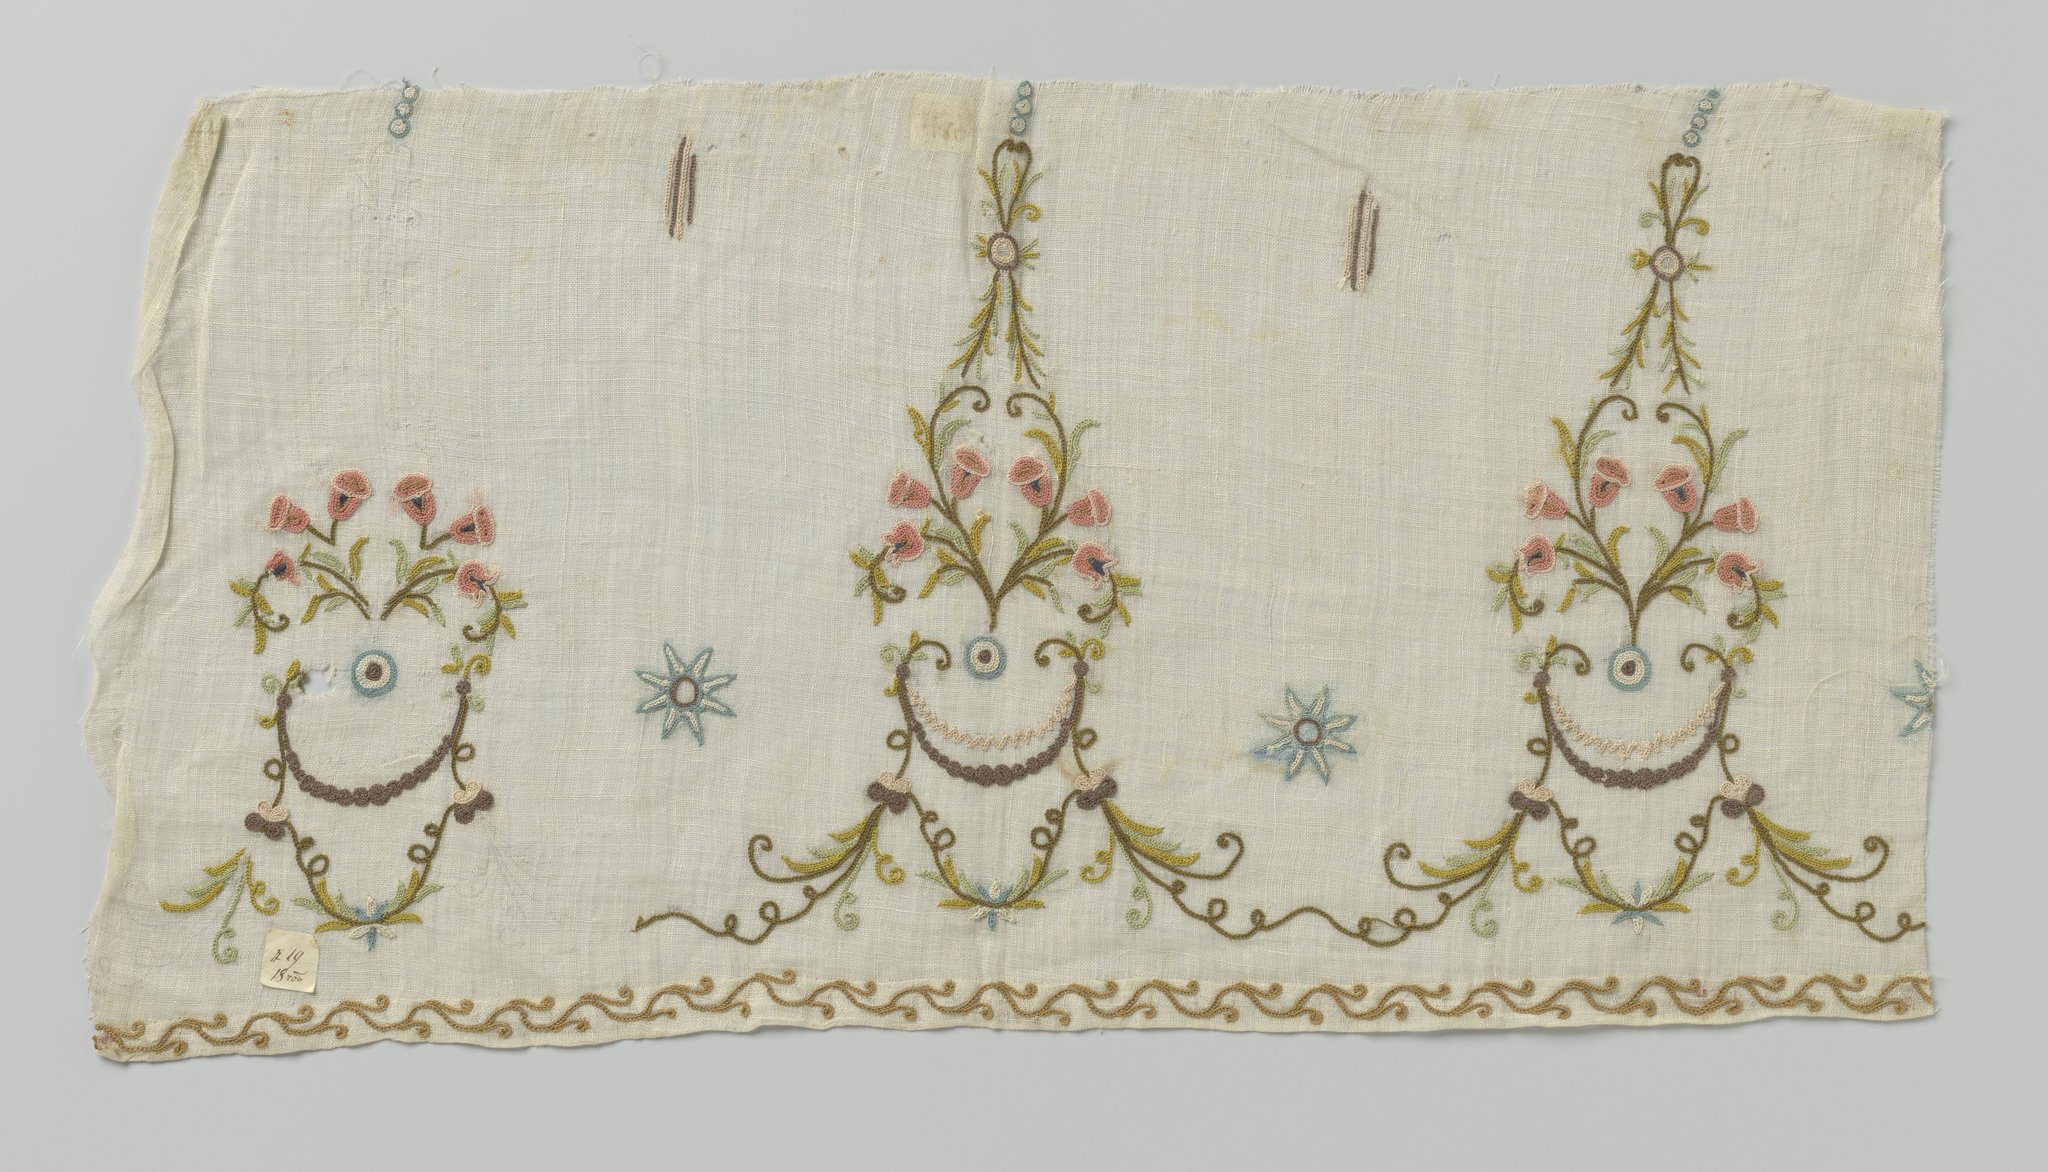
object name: fragment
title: Fragment wit zijdeweefsel met veelkleurig borduurwerk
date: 1750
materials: linen, silk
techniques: embroidered, weave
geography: spain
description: Fragment wit zijdeweefsel met borduurwerk. Het patroon heeft bloemtakken waaronder een parelguirlande. Vanuit de parelguirlande ontspringen krullende lijnen die de parelguirlandes aan elkaar verbinden.